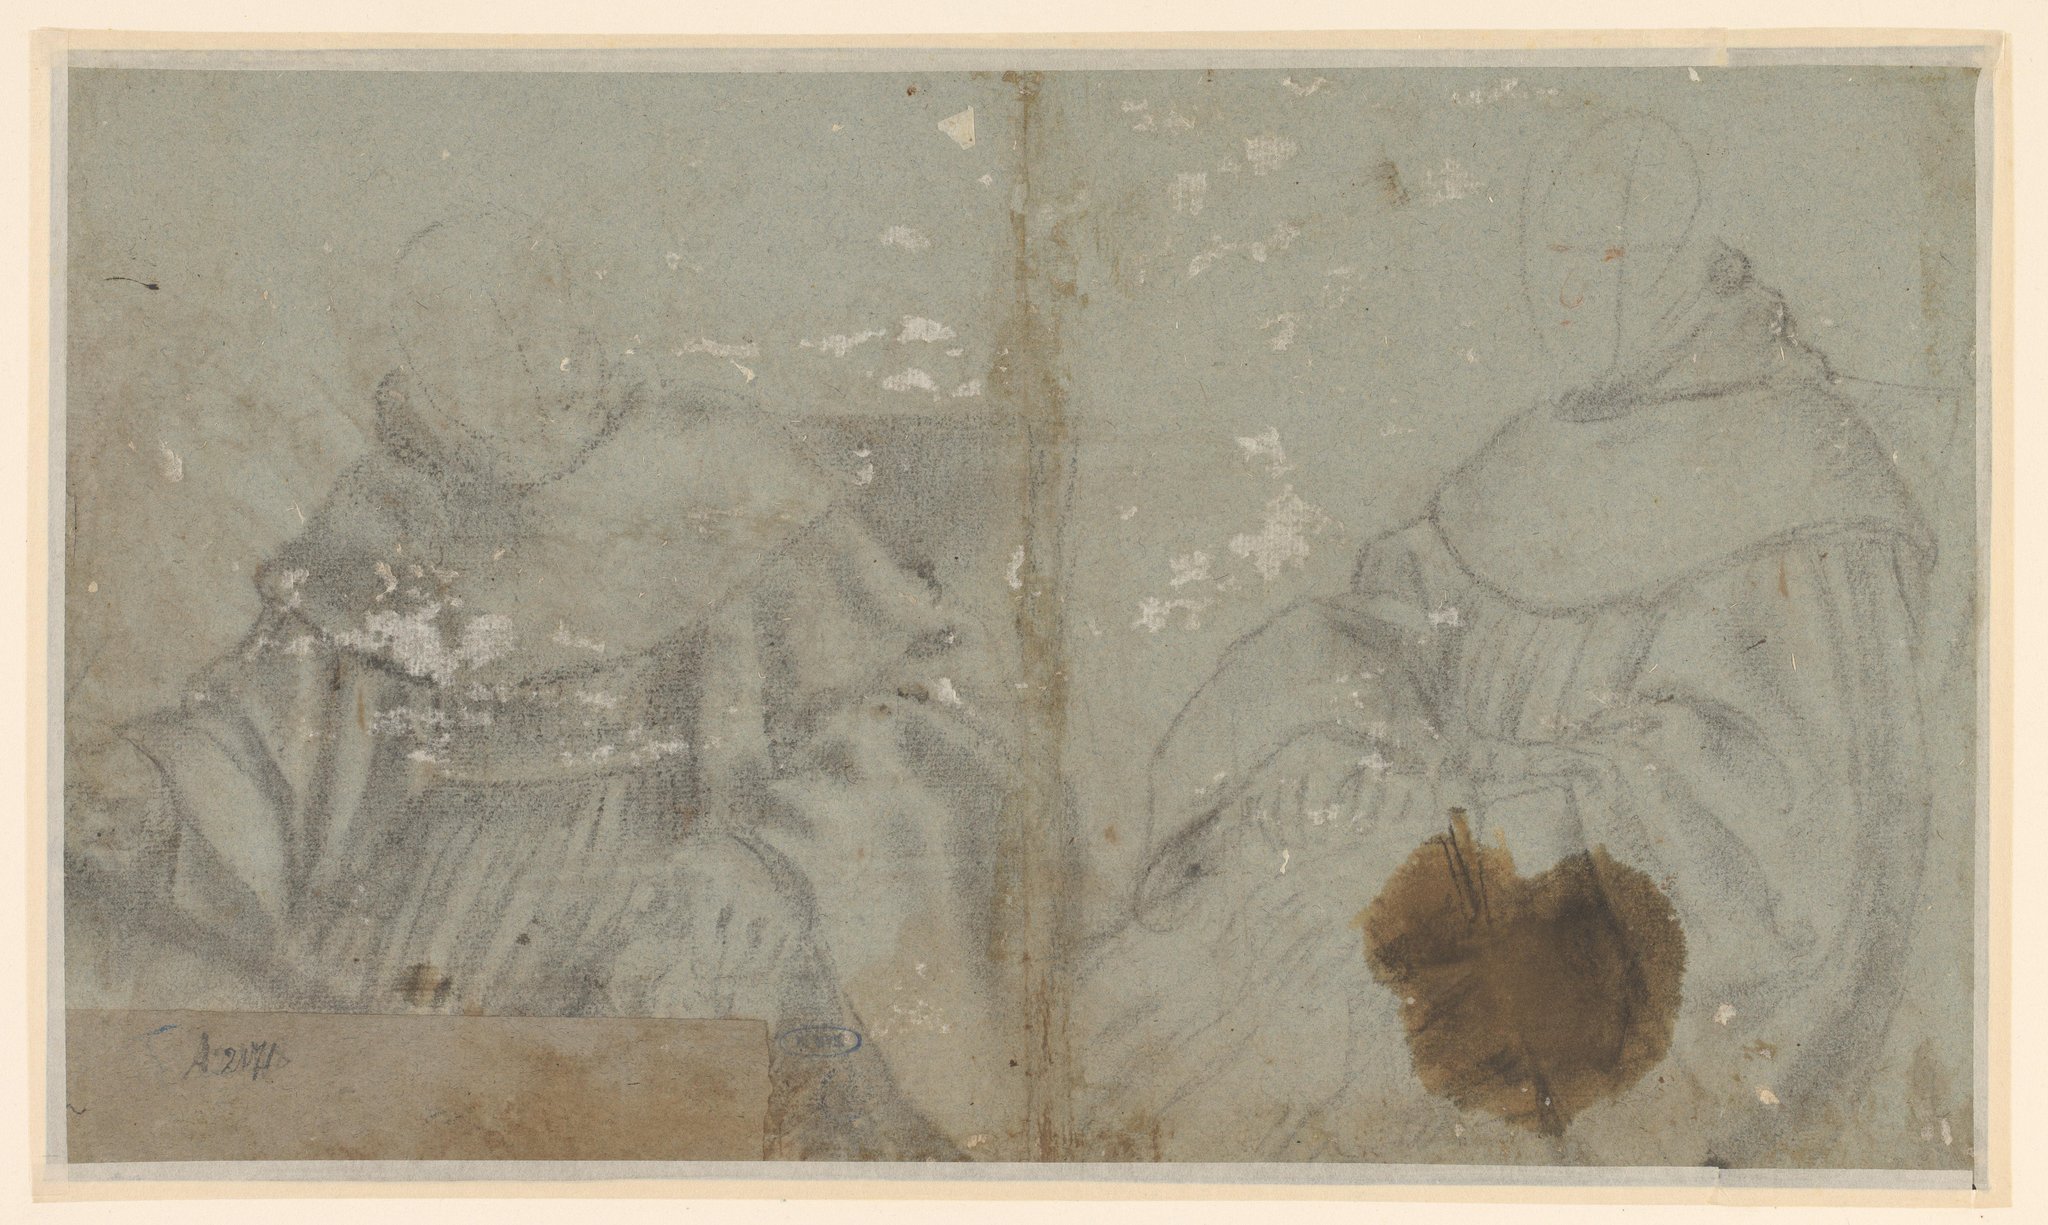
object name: drawing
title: Twee schetsen van zittende monniken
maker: Anonymous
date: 1520-1620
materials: chalk, paper